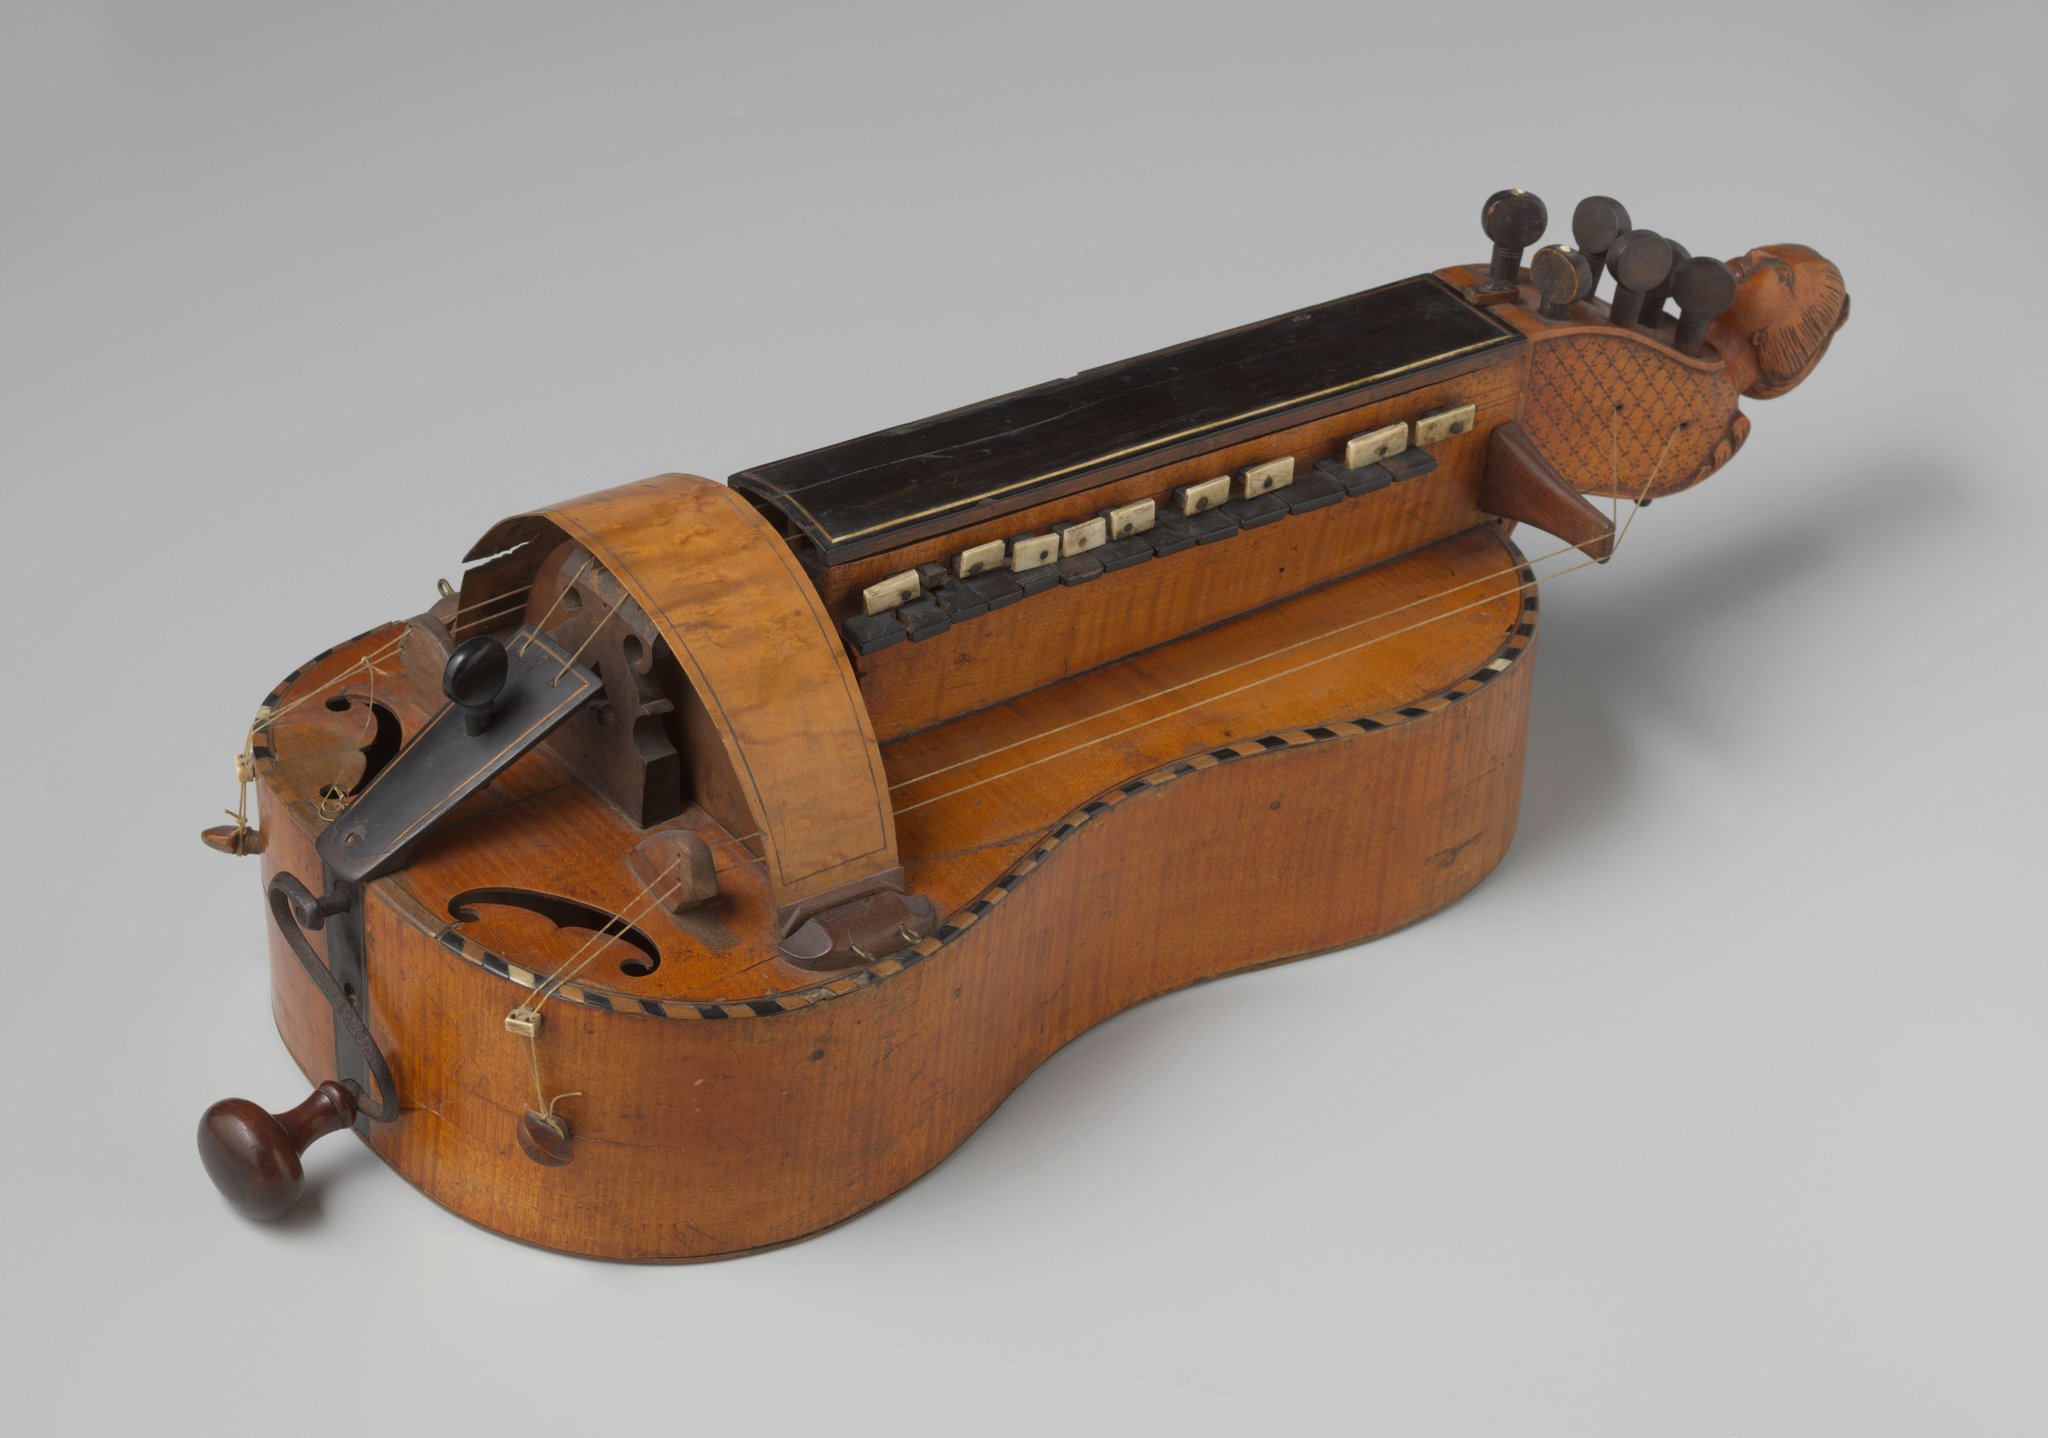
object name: hurdy gurdy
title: Hurdy-gurdy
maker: Anonymous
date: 1750-1800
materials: wood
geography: france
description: Draailier met kruk. De hals eindigigend in een vrouwenkop. Zes snaren. Gemerkt: driemaal: I.R.